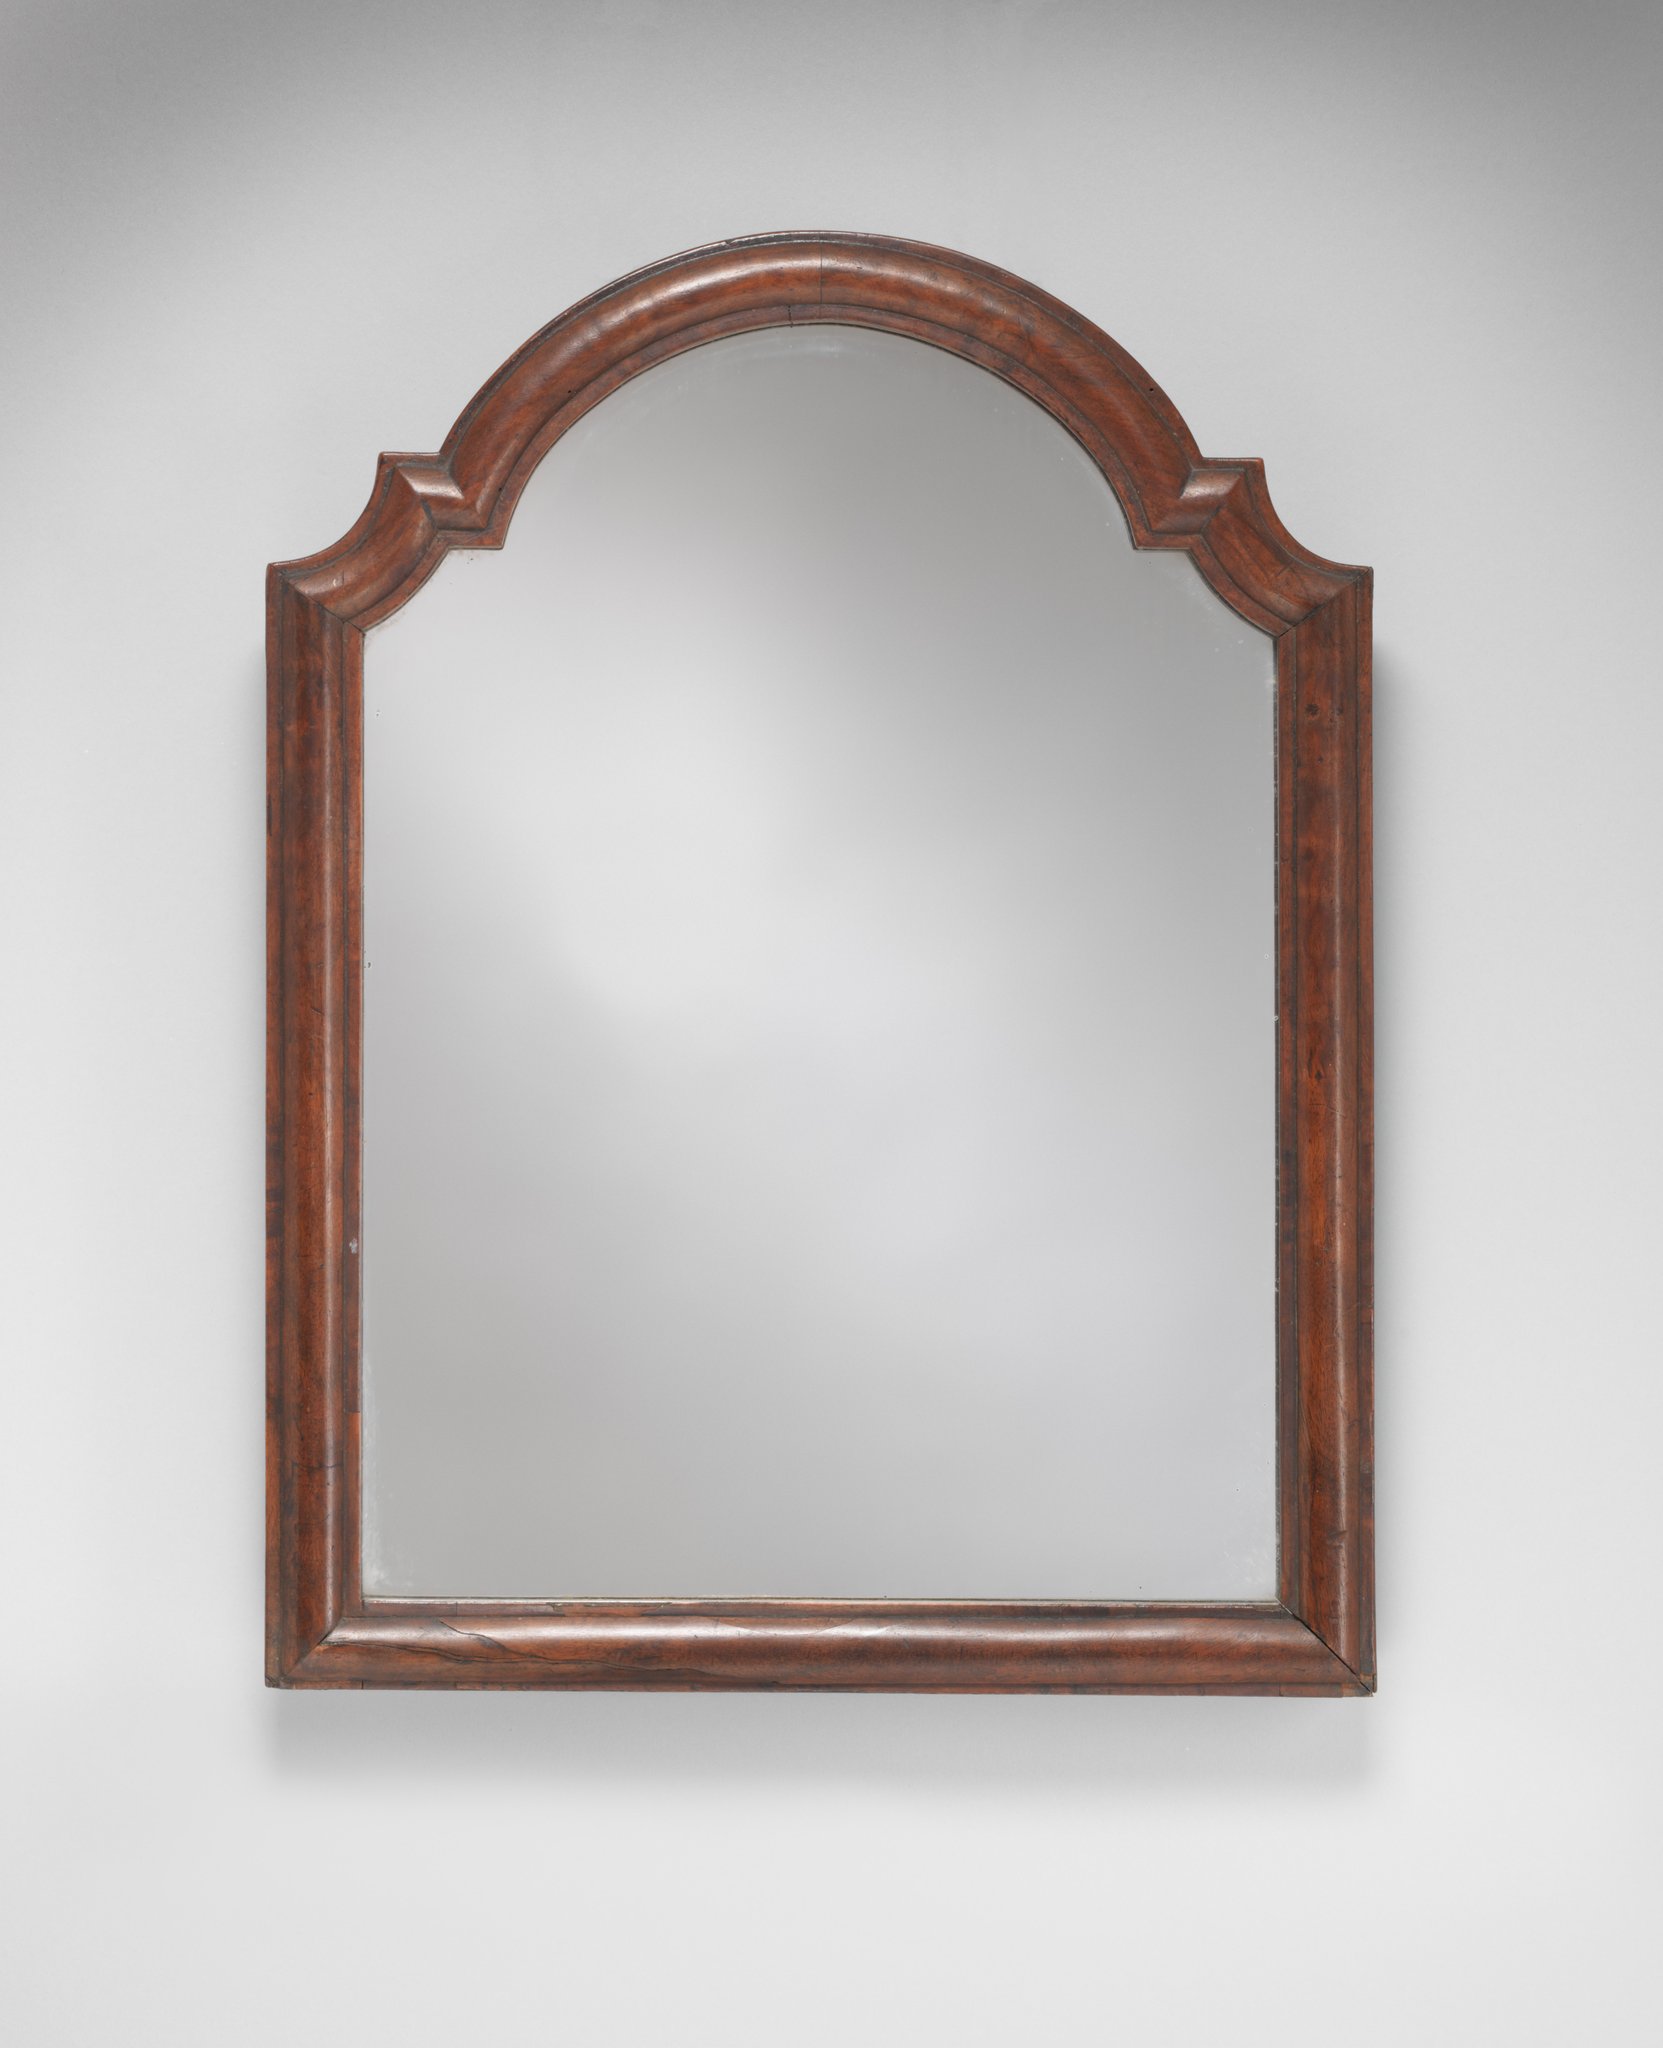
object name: mirror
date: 1701-1733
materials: glass, wood